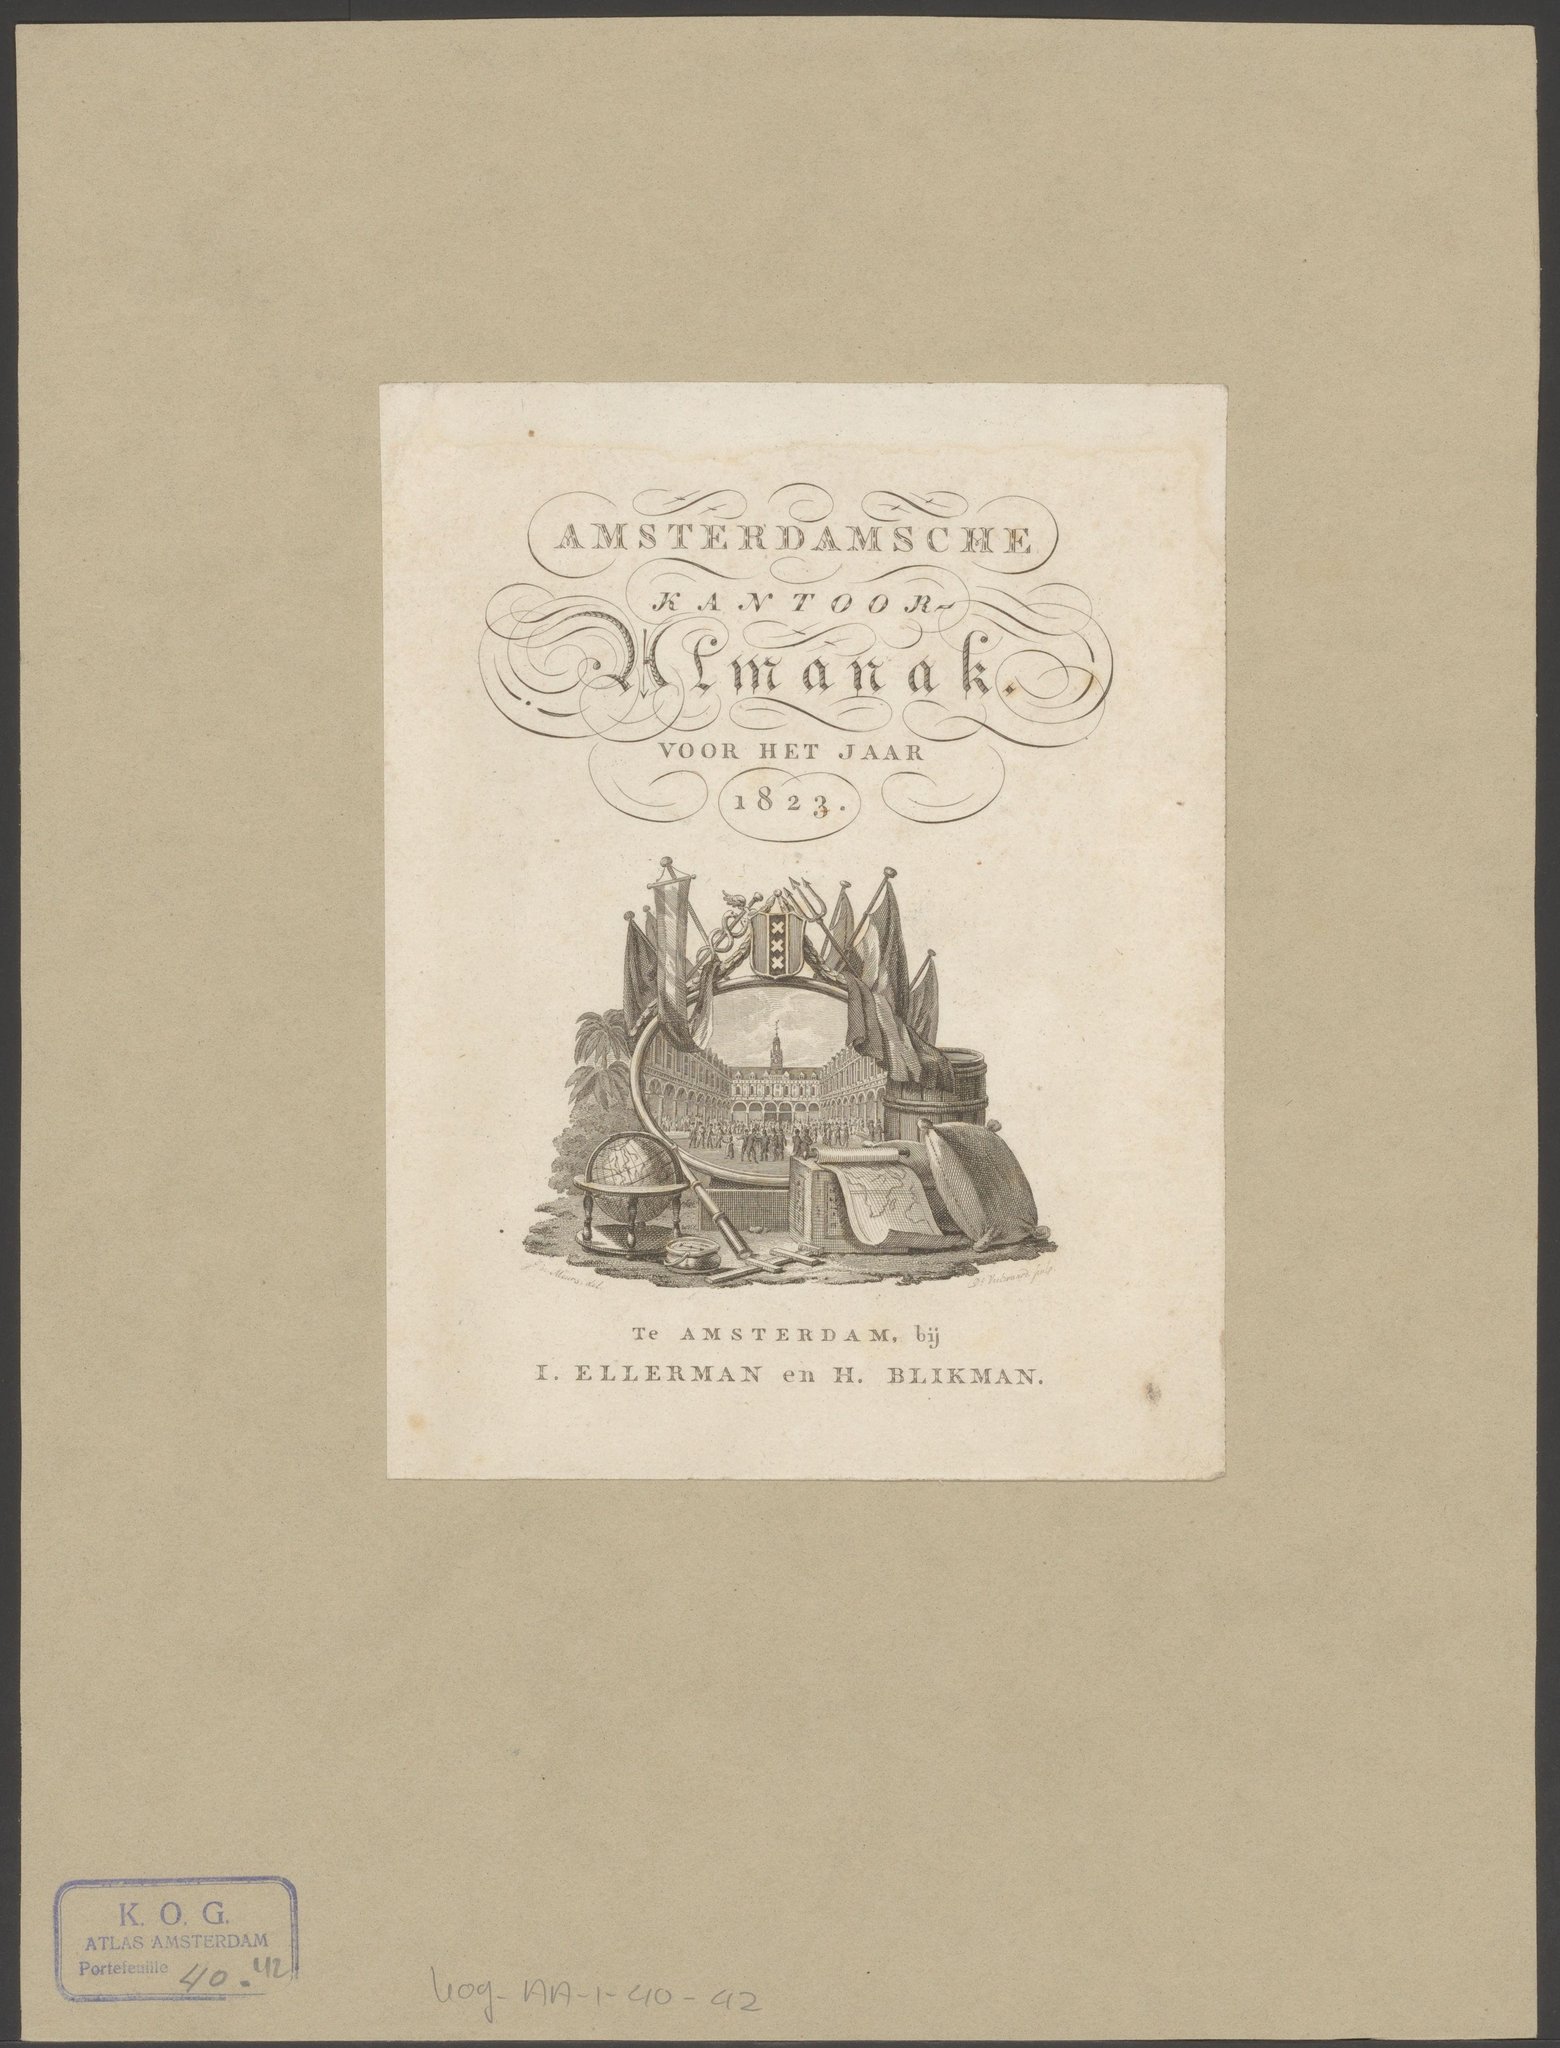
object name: titelblad, titelpagina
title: Titelpagina voor: Amsterdamsche Kantoor-Almanak voor het jaar 1823, [1822]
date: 1822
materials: paper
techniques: engraving, etching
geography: amsterdam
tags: coat of arms (as symbol of the state, etc.) (+ city; municipal), stock exchange, stock-market, courtyard, globe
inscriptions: collector's mark: Lugt 1641b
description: Titelpagina voor: Amsterdamsche Kantoor-Almanak voor het jaar 1823. Amsterdam: Isaac Ellerman en Hendrik Blikman, [1822].